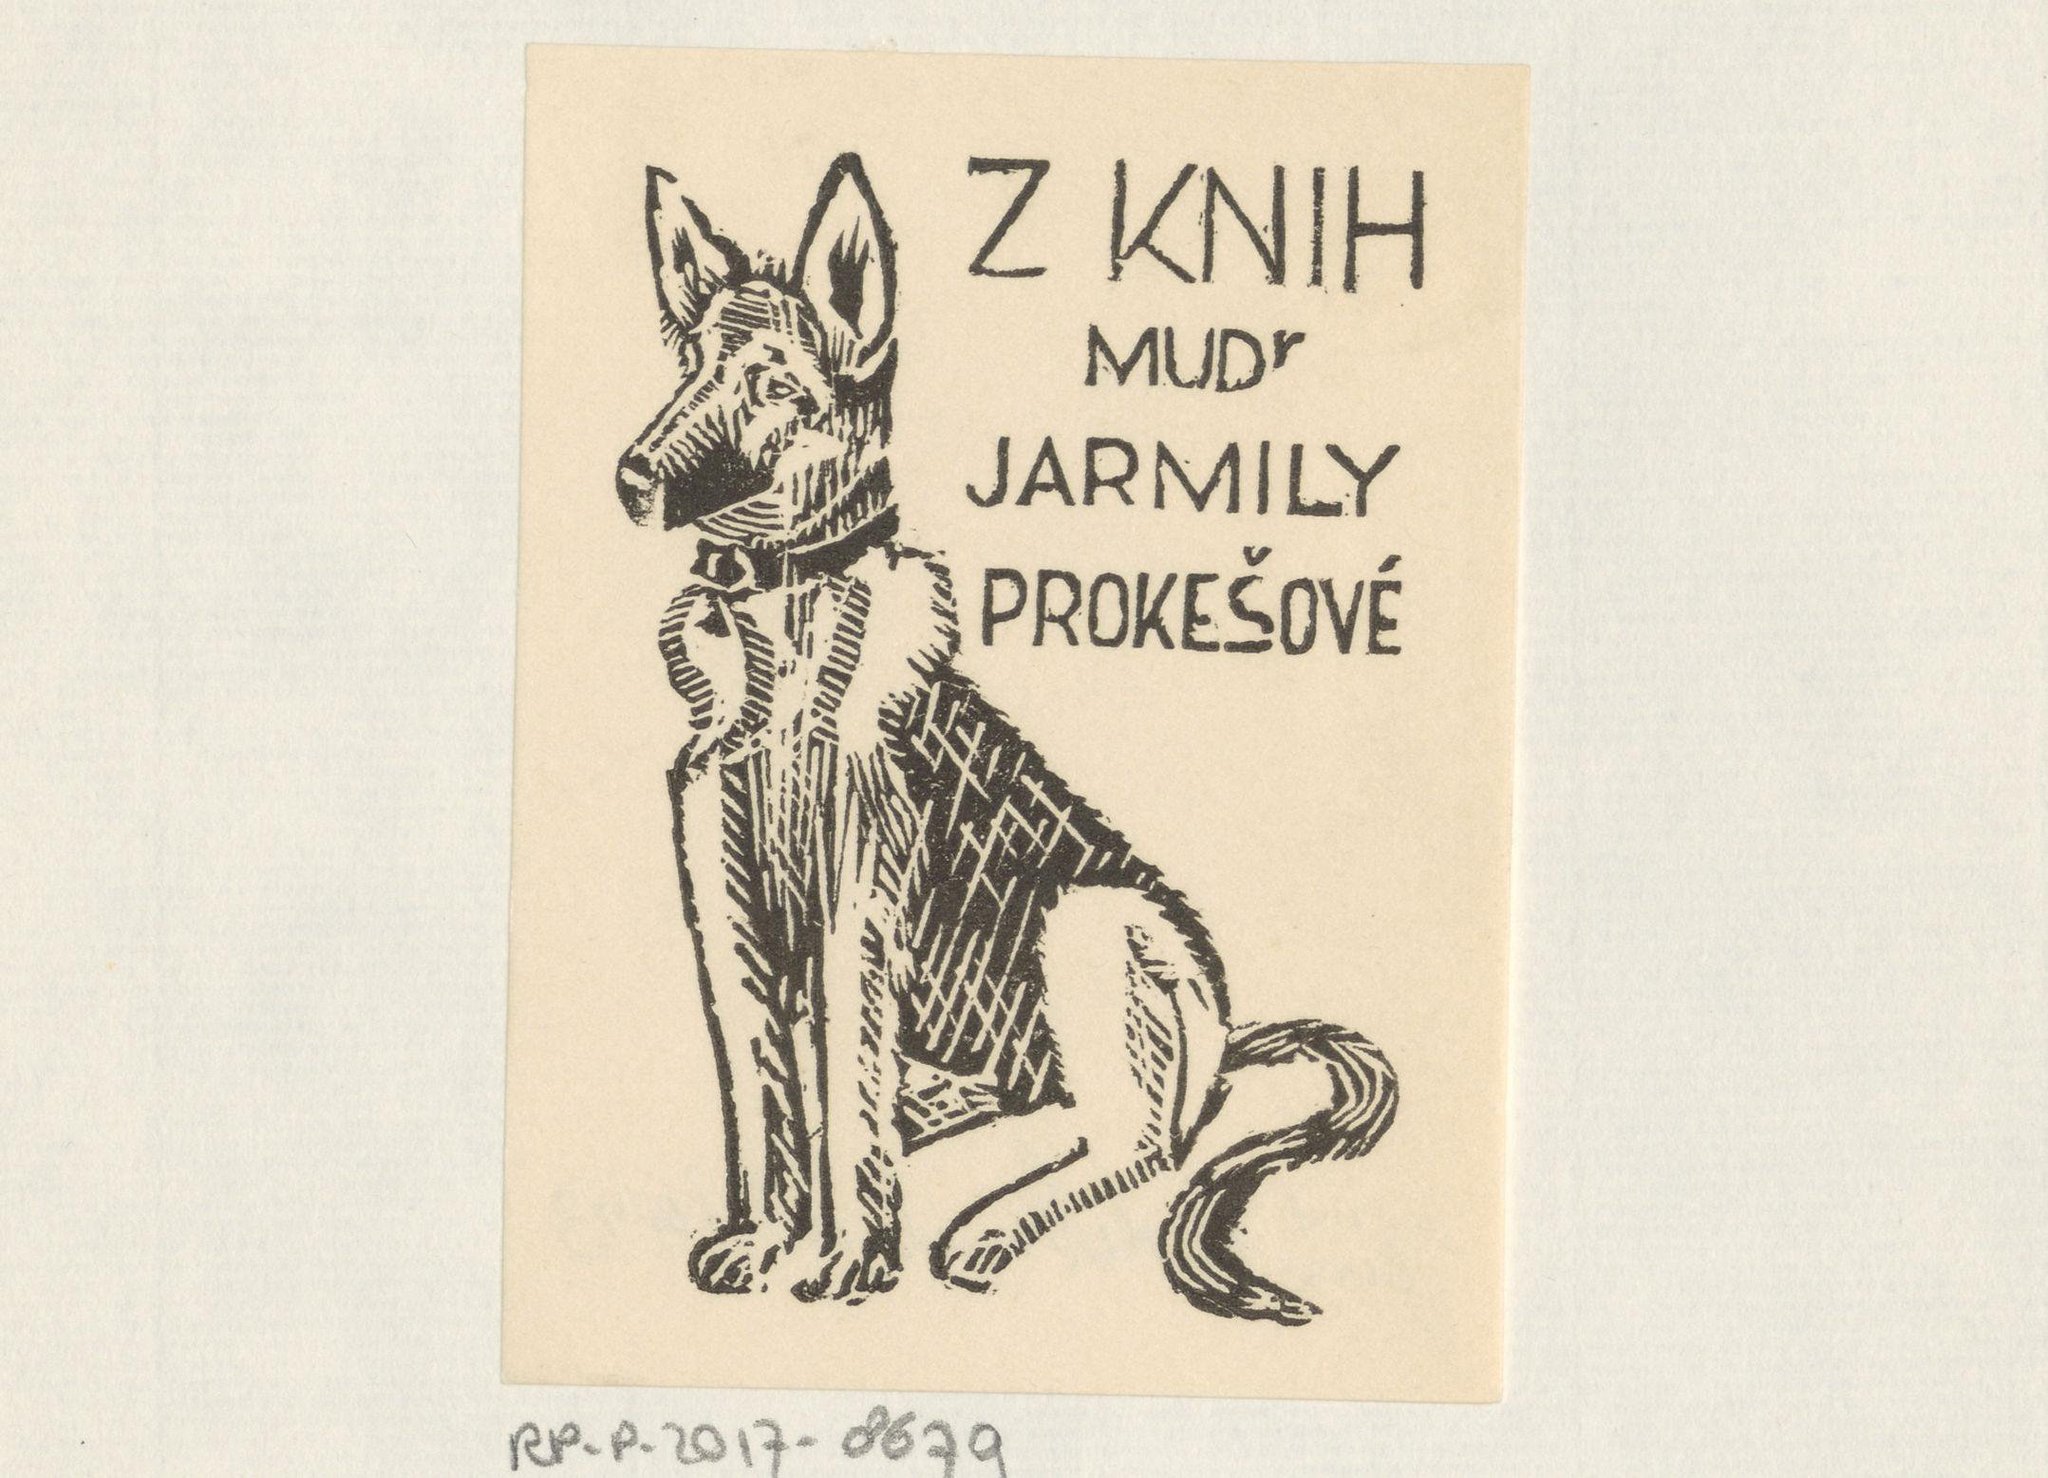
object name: bookplate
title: Ex libris van Jarmila Prokešová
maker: jiří vodehnal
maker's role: print maker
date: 1943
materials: paper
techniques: woodcut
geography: czech republic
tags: cat